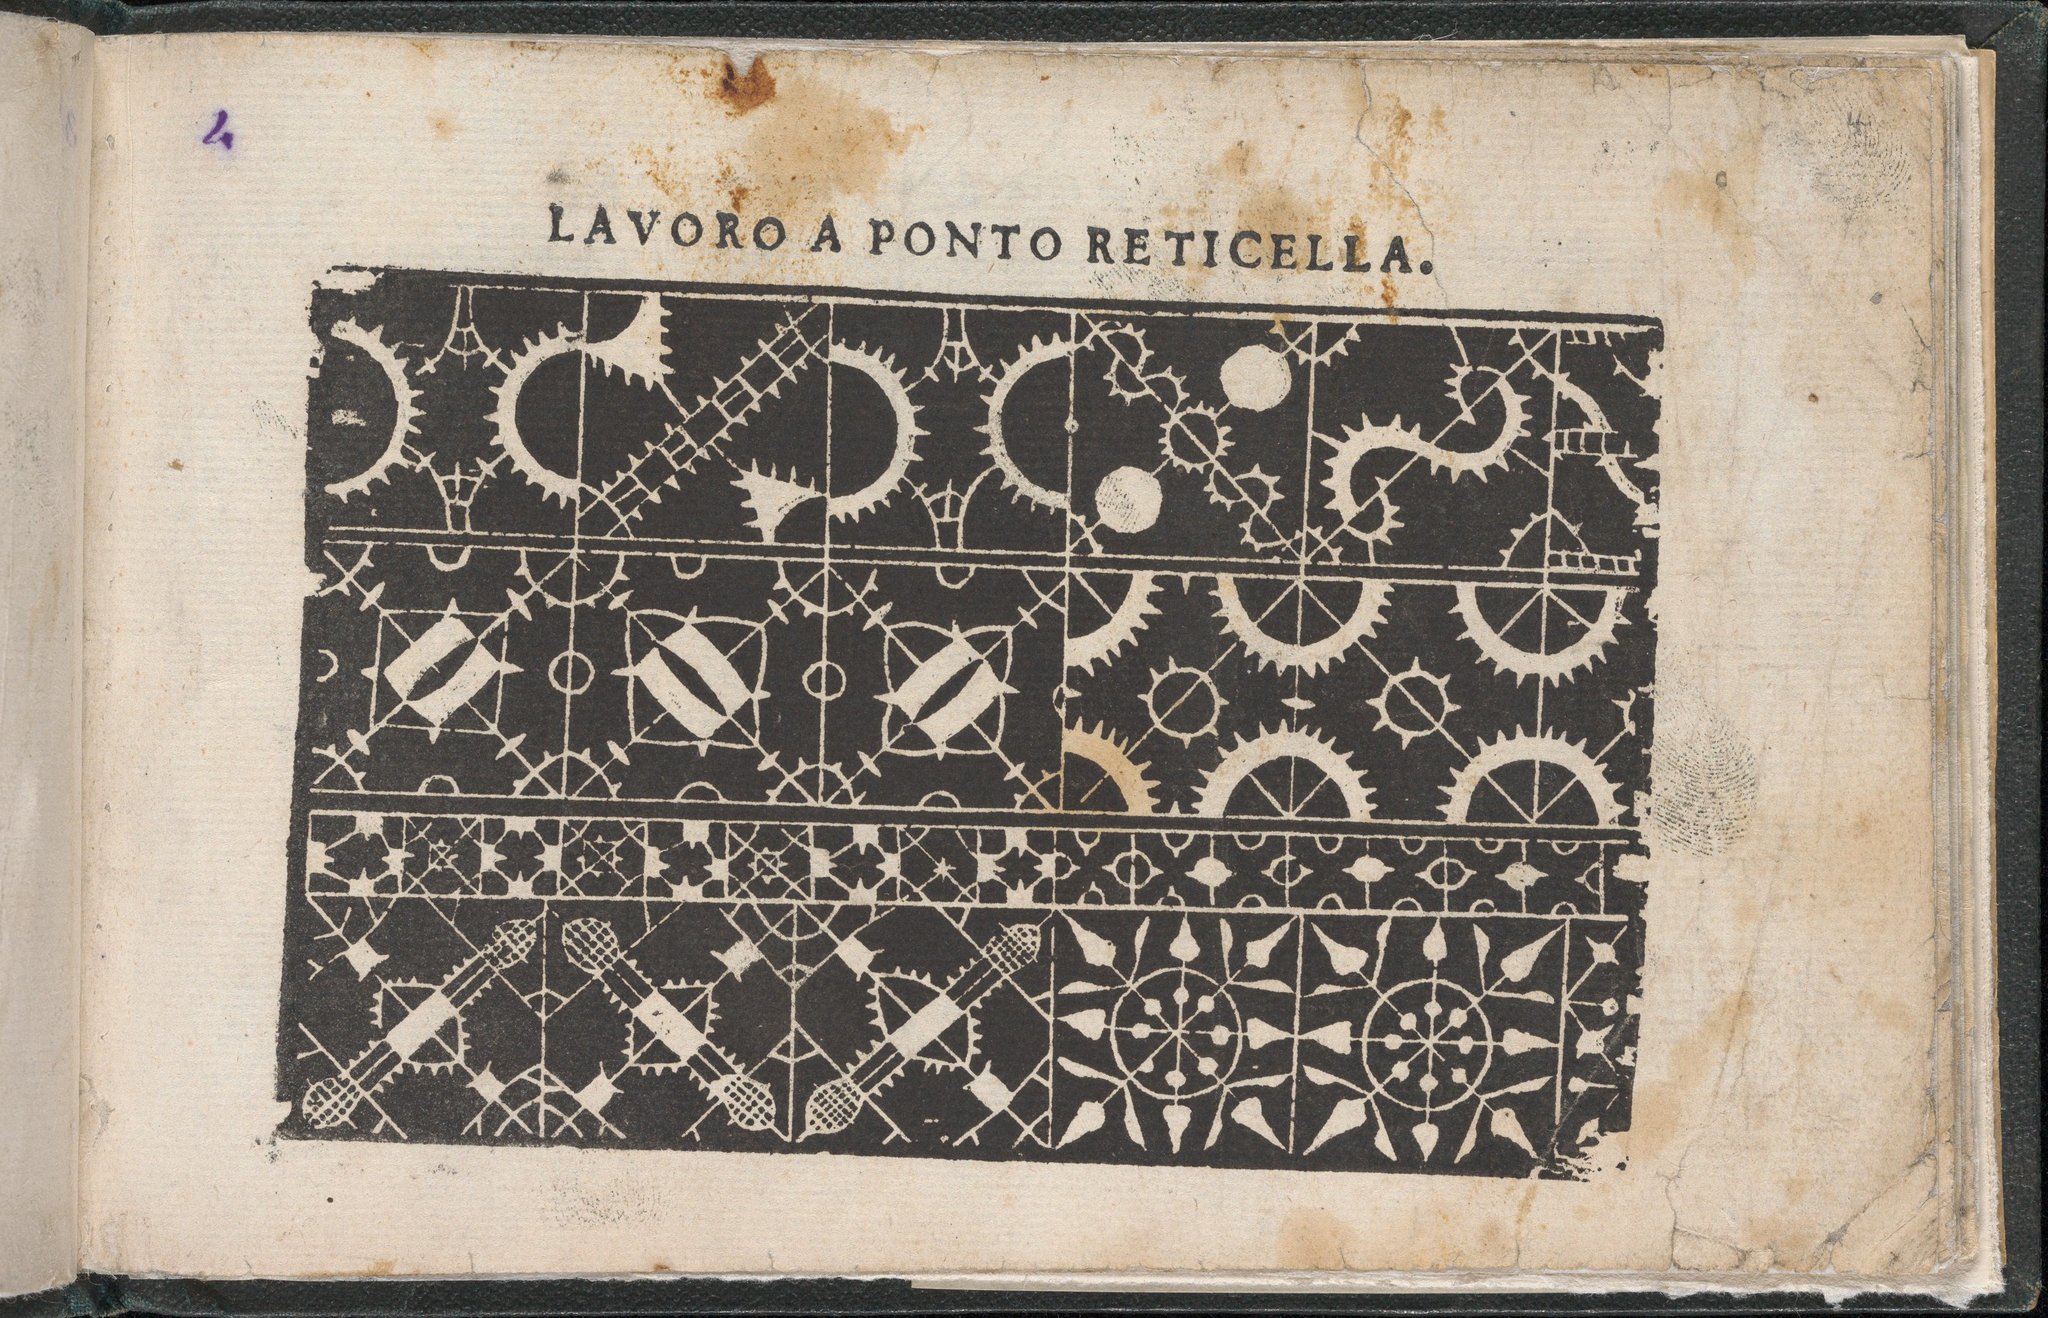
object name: book print ornament architecture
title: Gemma pretiosa della virtuose donne, page 4 (recto)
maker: isabella catanea parasole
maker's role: designer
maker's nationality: italian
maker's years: 1565-1625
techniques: woodcut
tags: ornament